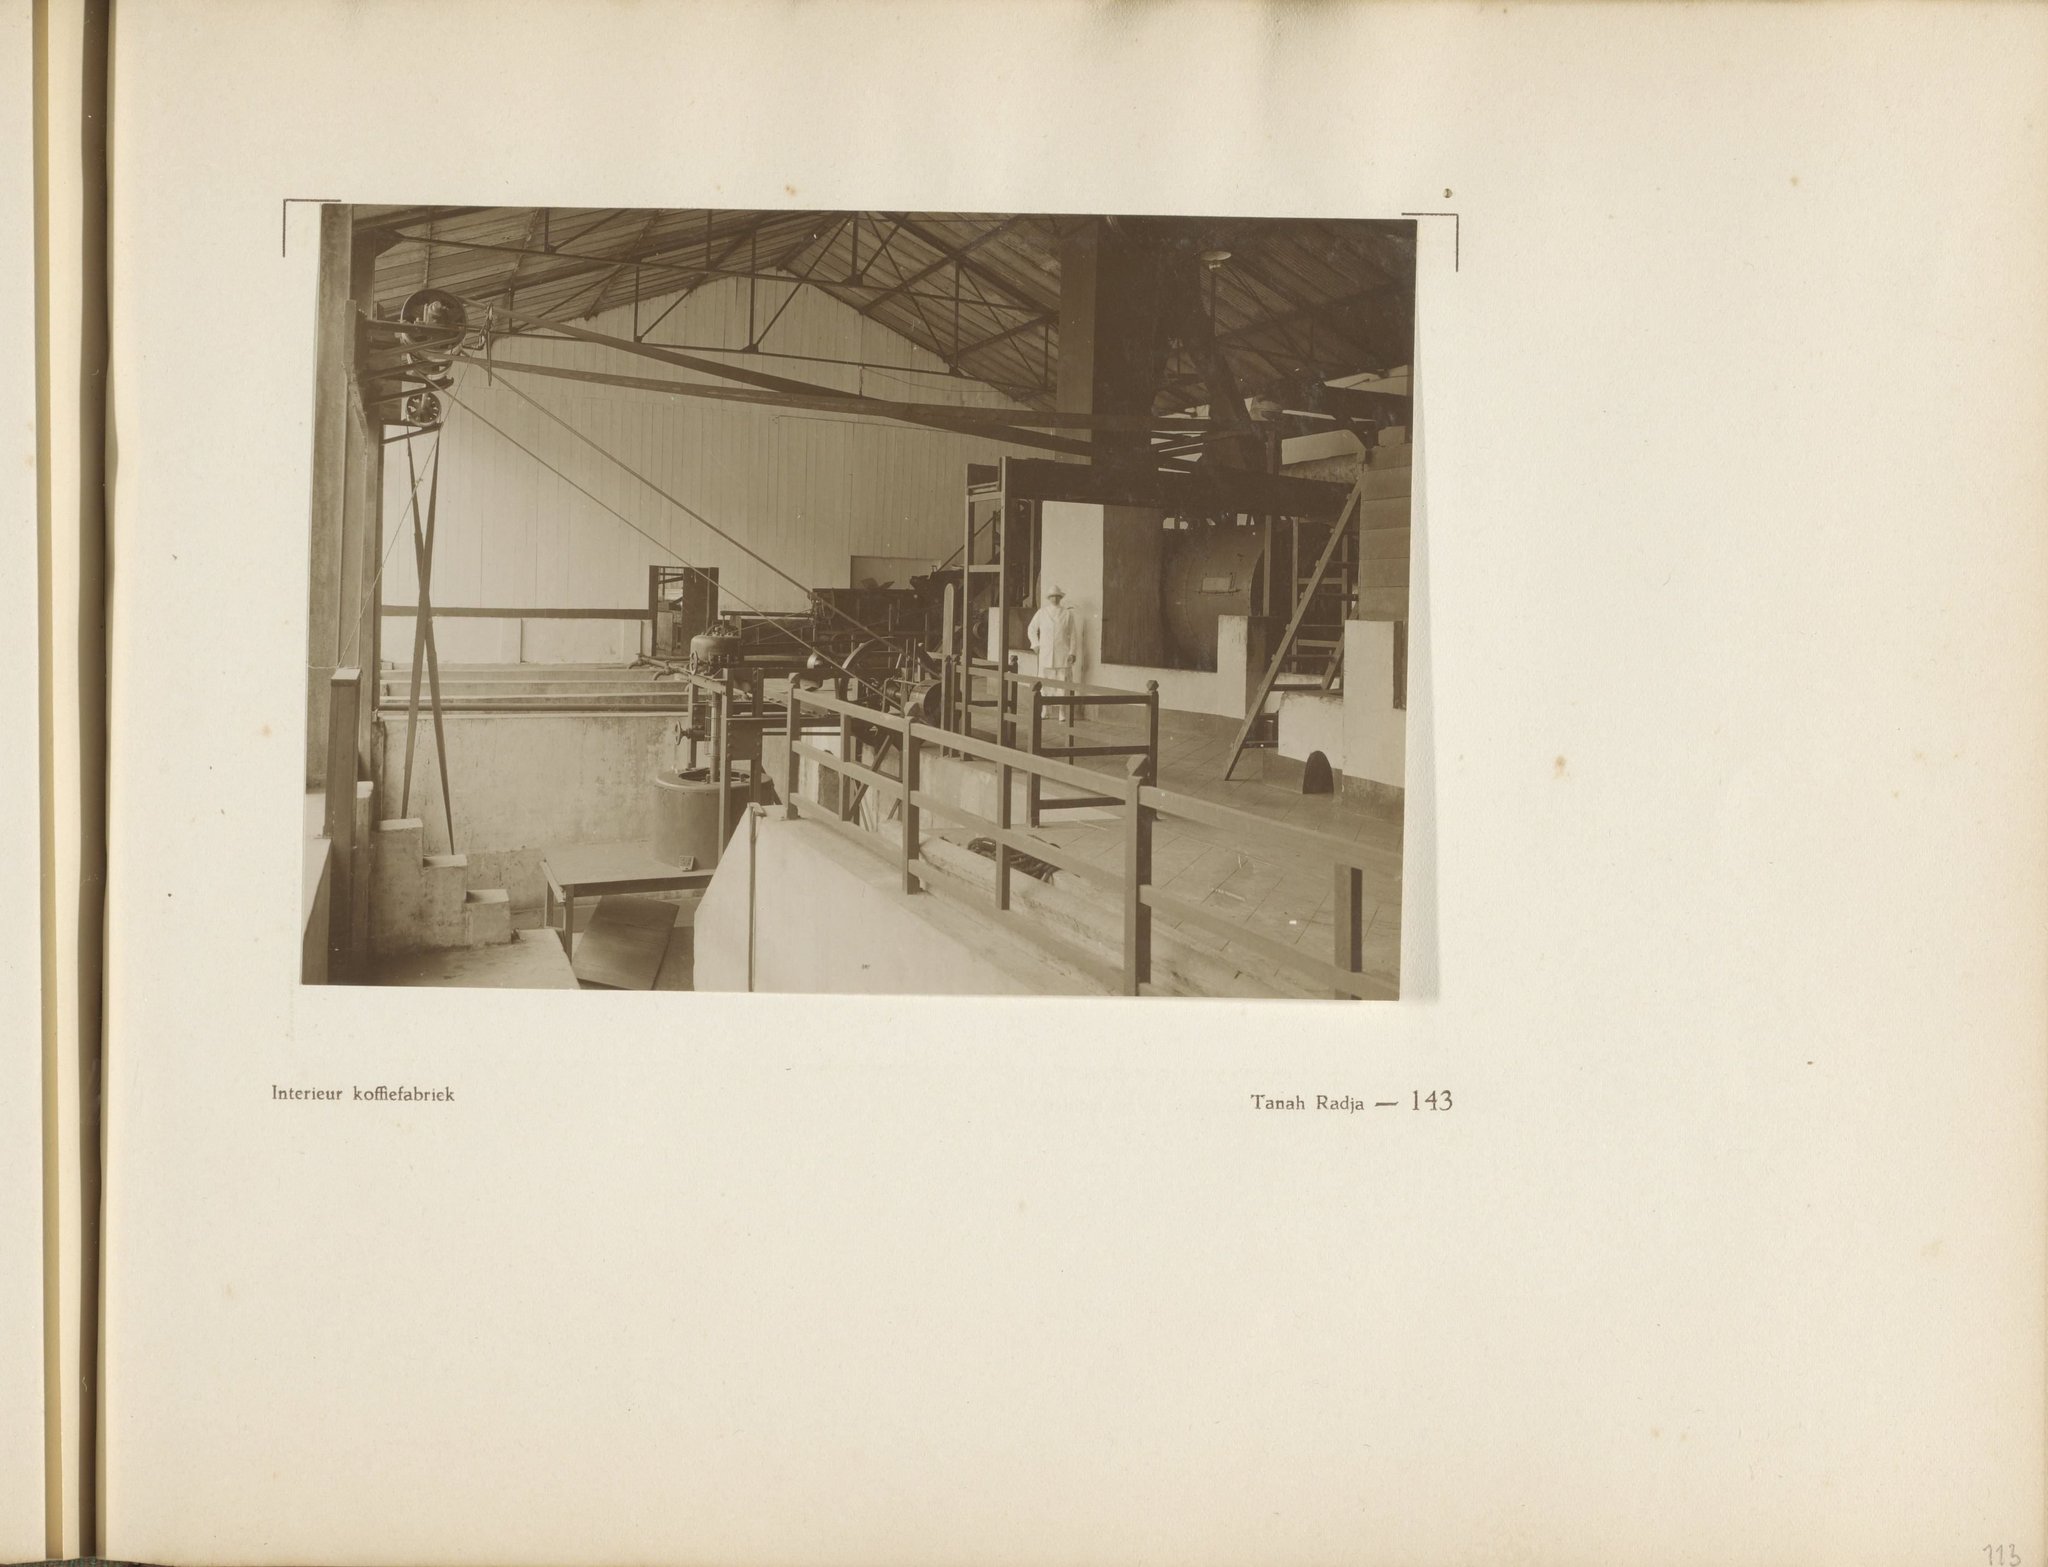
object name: album leaf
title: Pagina 143 van fotoboek van de Algemeene Vereeniging van Rubberplanters ter Oostkust van Sumatra (A.V.R.O.S.)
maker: j.w. meyster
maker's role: fotograaf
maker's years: 1887-1945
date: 1924-1925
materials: paper, photographic support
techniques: printing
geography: dutch east indies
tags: coffee, factory-interior, machine shop, (non-fruit) products of plants or trees: rubber, machines, engines ~ crafts and industries (+ agricultural processes), sumatra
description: Boekpagina met een foto van het interieur van een koffiefabriek te Tanah Radja. Onderdeel van een fotoboek van de Algemeene Vereeniging van Rubberplanters ter Oostkust van Sumatra (A.V.R.O.S.).